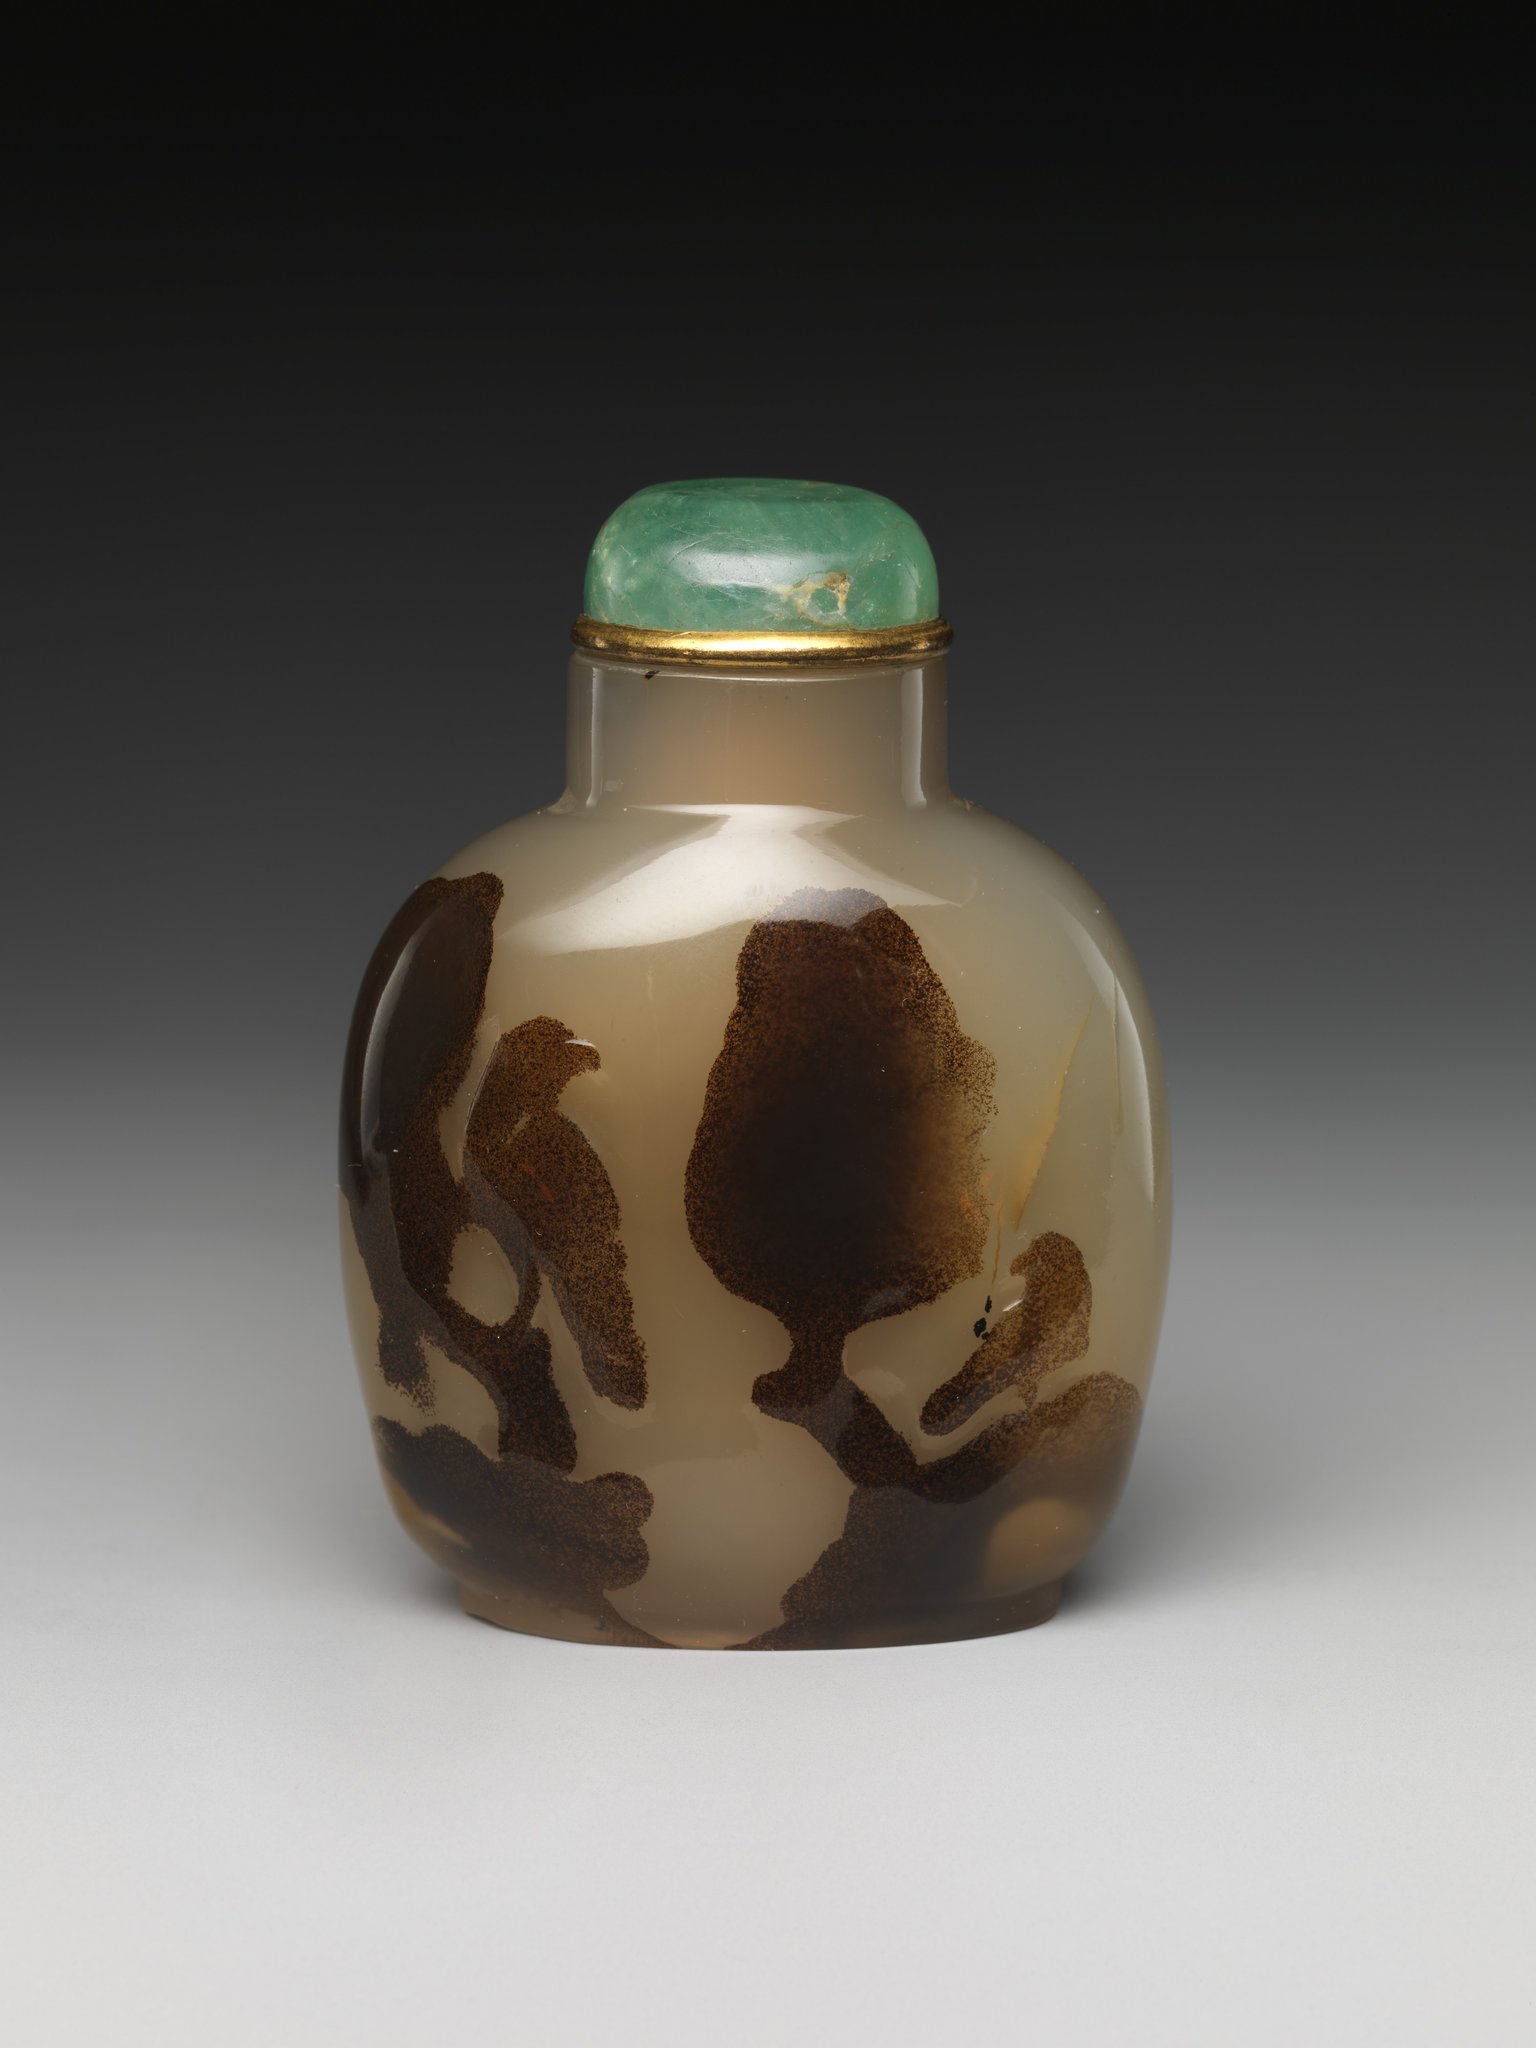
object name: snuff bottle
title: Snuff Bottle with Two Eagles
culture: chinese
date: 1767-1833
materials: stone, jade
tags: eagles